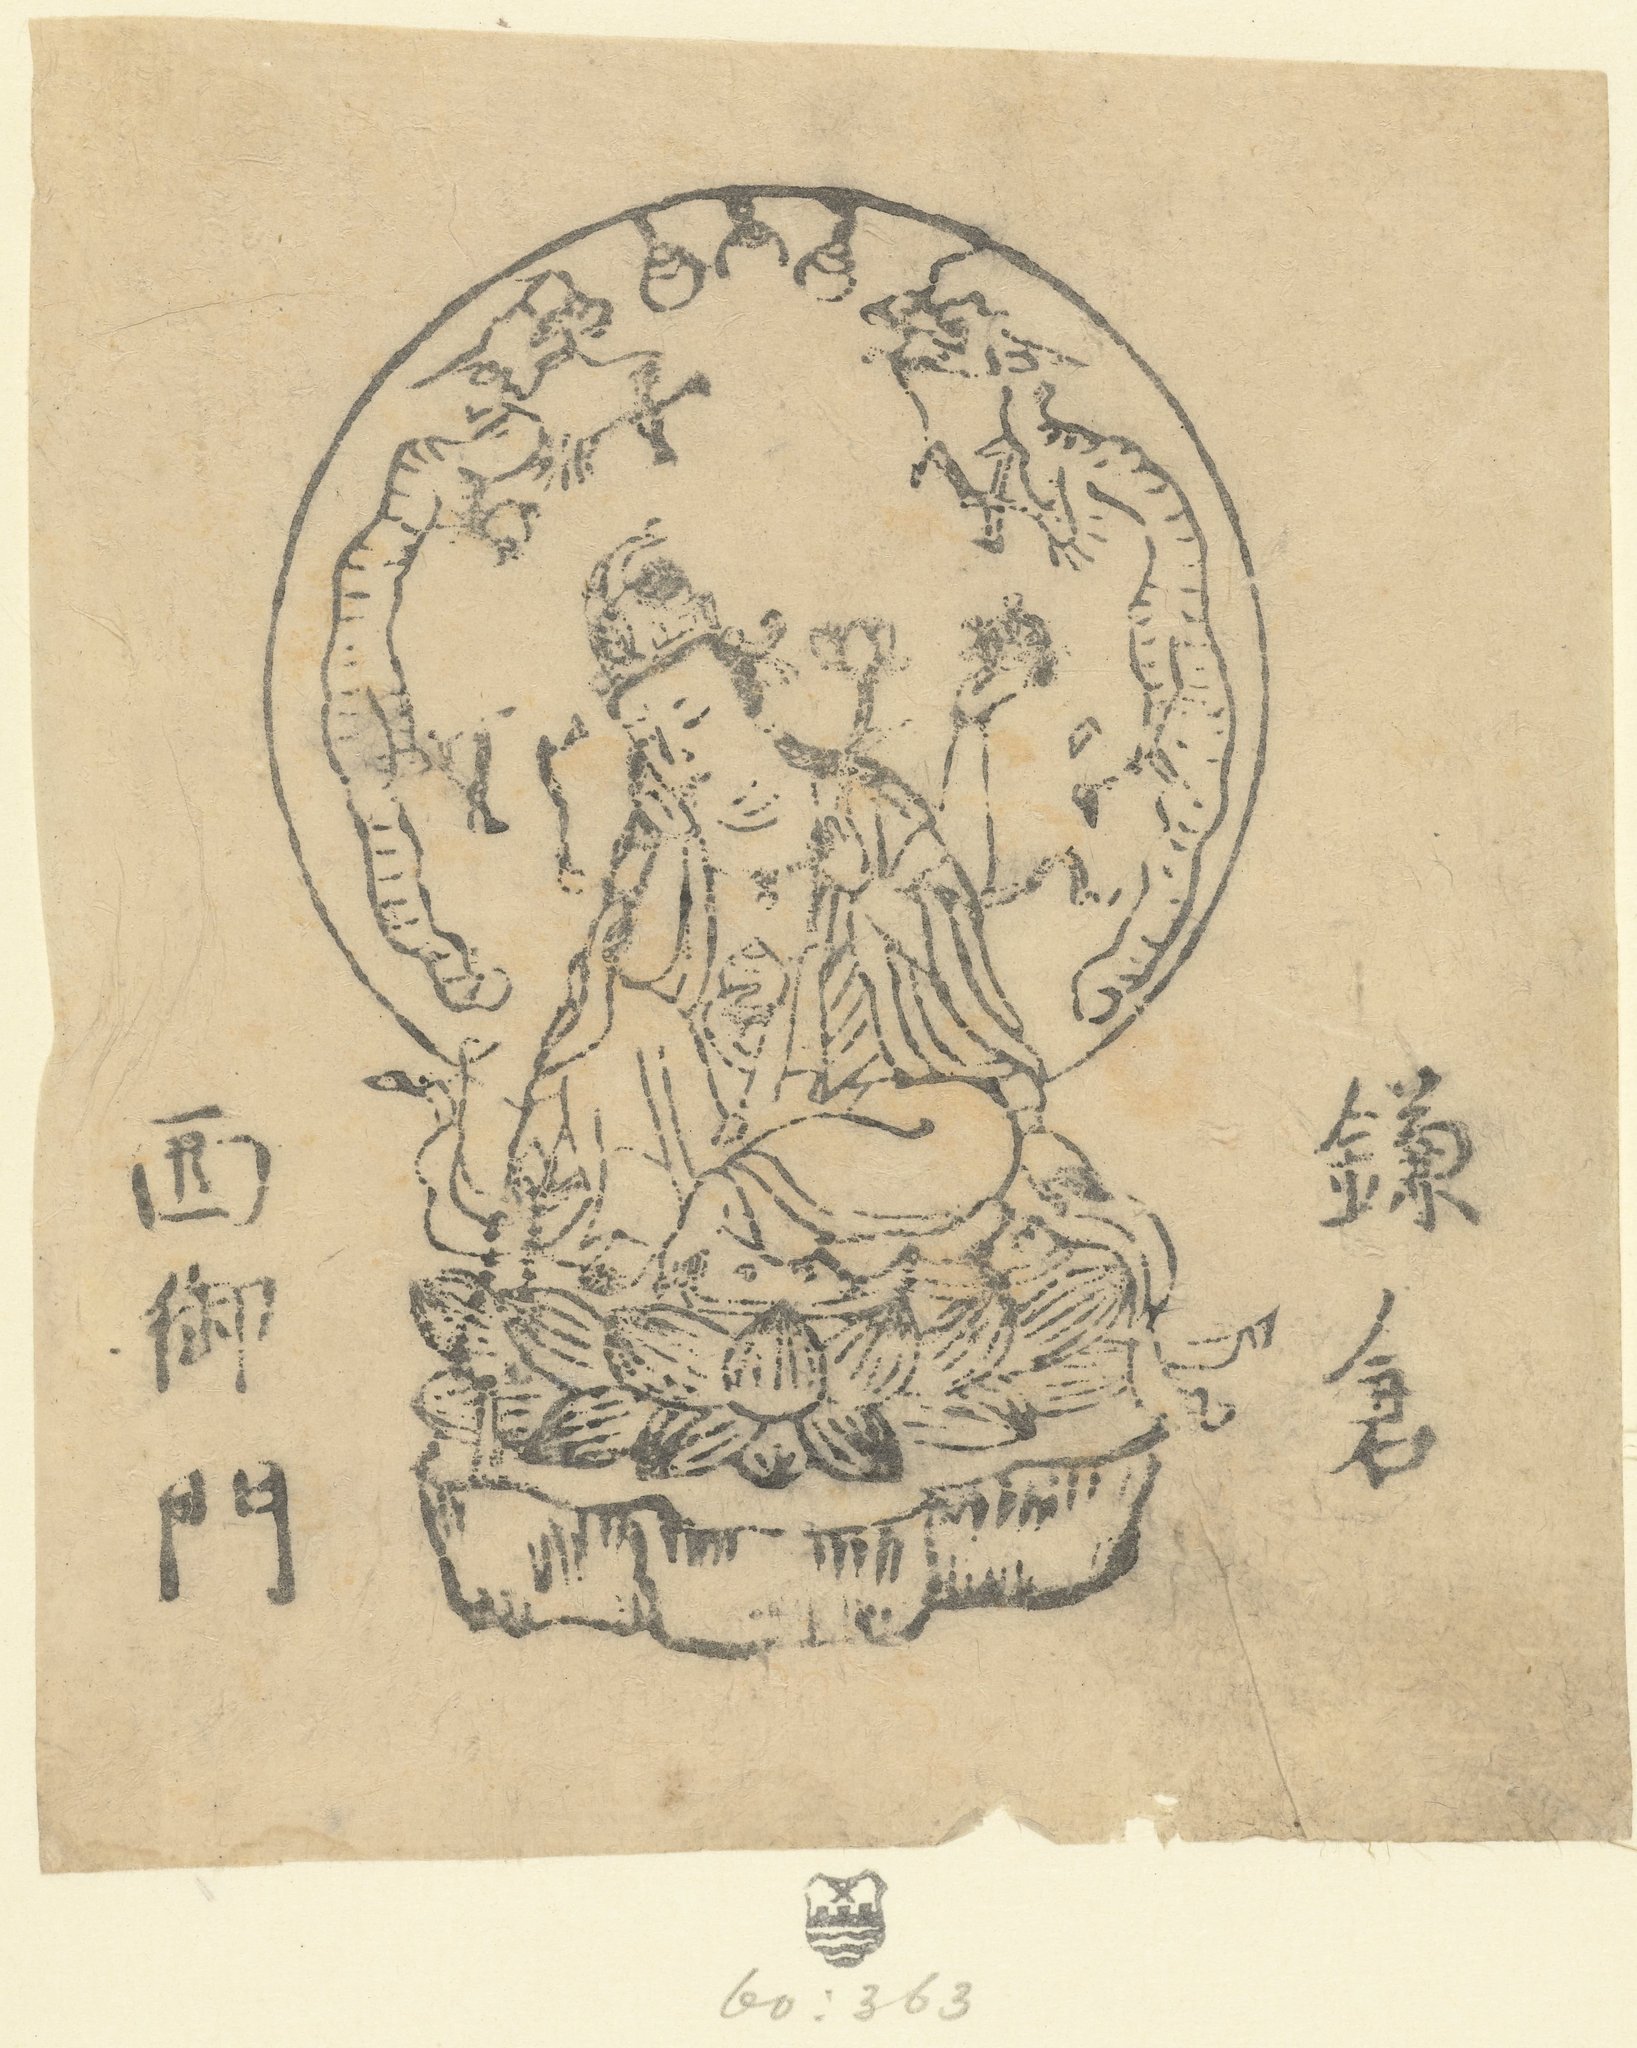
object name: print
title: Kamakura, Nishimikado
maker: Anonymous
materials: paper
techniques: woodcut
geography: japan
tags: representations ~ gods, demi-gods, heroes, etc. (hinduism, buddhism, jainism)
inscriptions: collector's mark: Lugt 2760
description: Bodhisattva zittend op lotusbloem tegen cirkelvormige achtergrond waarin twee draken.